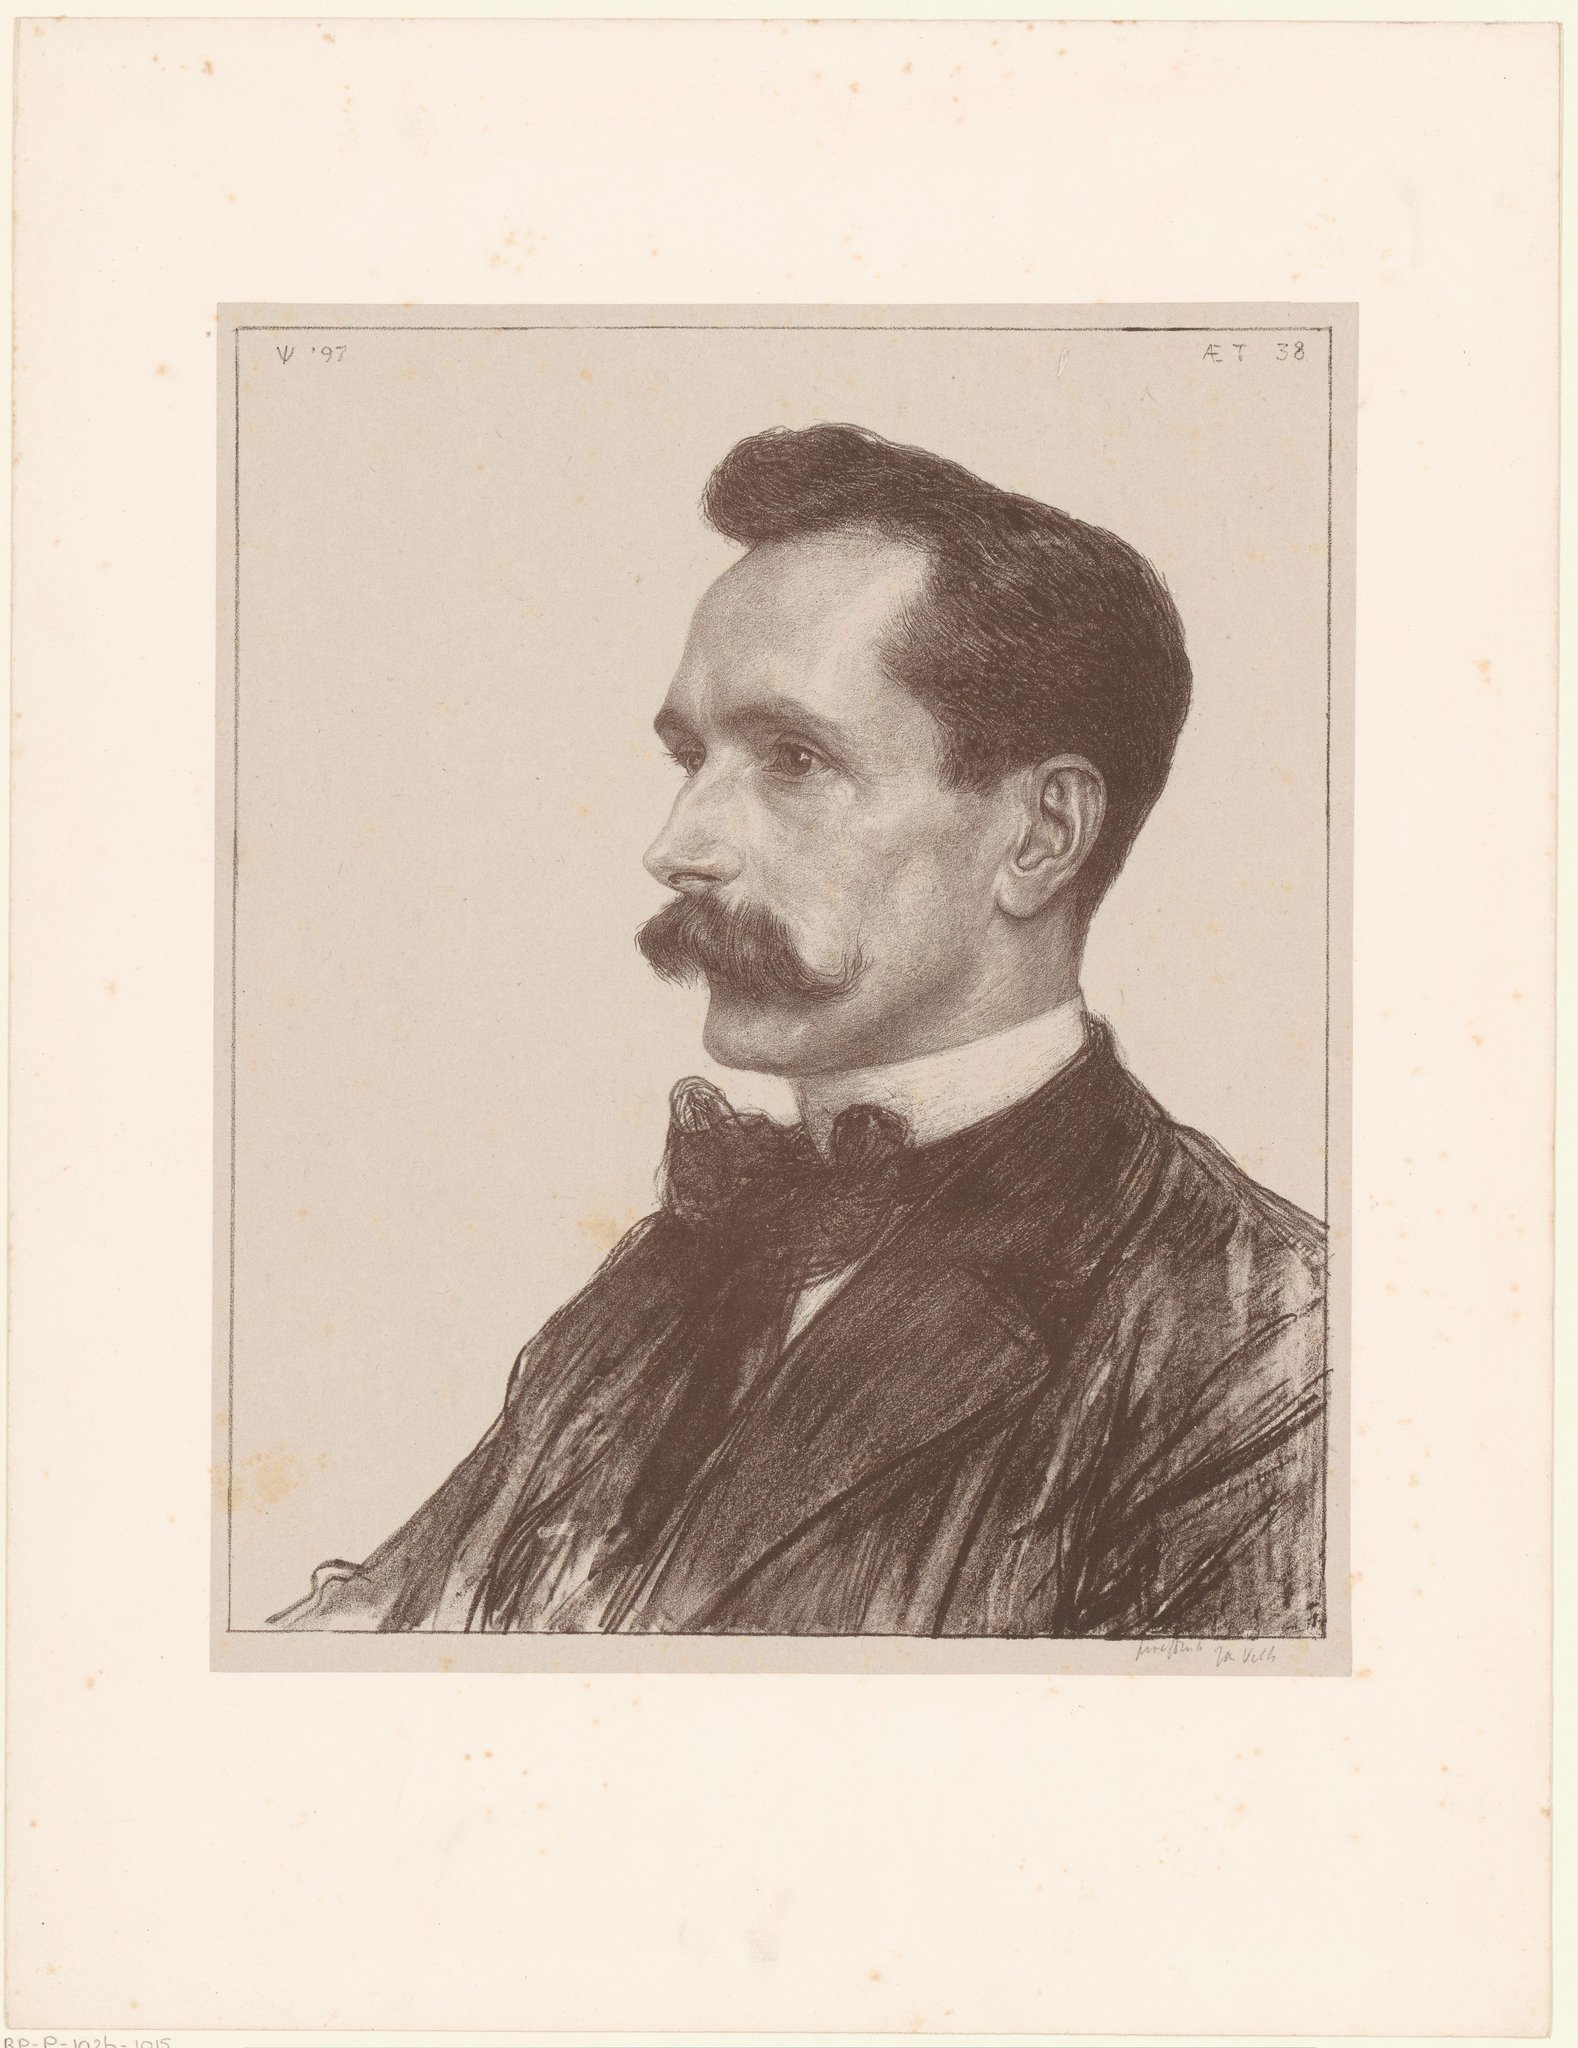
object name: print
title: Portretten van de Kroniek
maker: jan veth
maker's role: designer, draughtsman, painter, print maker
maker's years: 1864-1925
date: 1897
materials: paper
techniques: lithograph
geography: netherlands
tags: voorschoten, the hague, politician, historical persons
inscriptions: collector's mark: ‘H.G. Samson Amsterdam’, collector's mark: Lugt 2228, inscription: ‘proefdruk / Jan Veth’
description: Dit portret werd uitgegeven als bijvoegsel bij De Kroniek op 30 mei 1897.